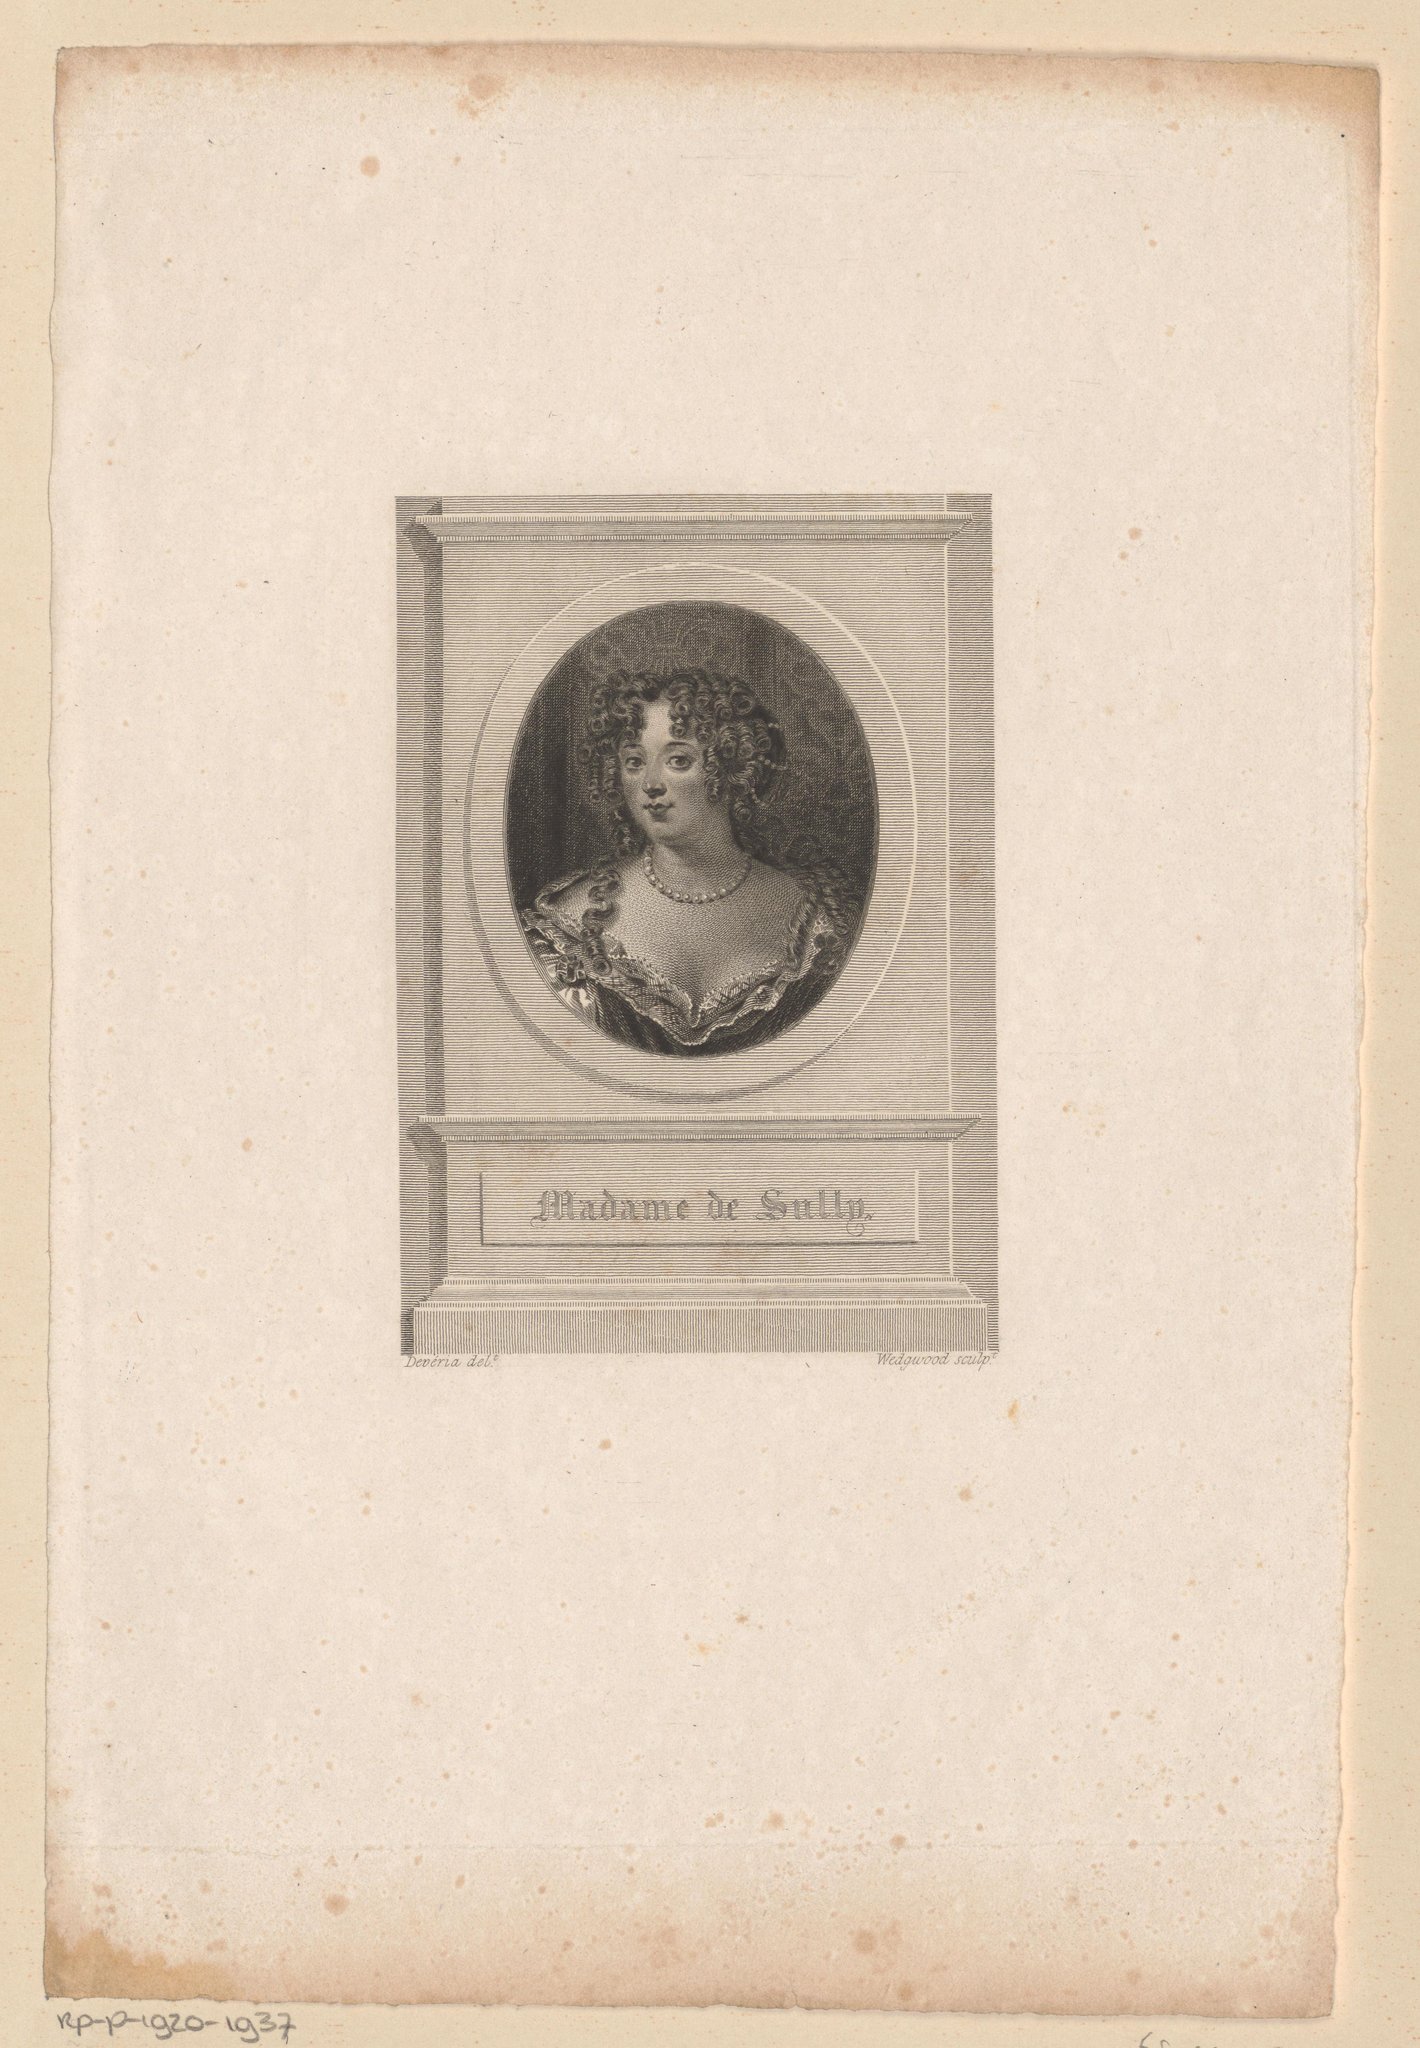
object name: print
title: Portret van Marie-Antoinette Servien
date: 1829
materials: paper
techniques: etching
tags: historical persons - bb - woman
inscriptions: collector's mark: Lugt 2228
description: Prent waarschijnlijk uit: Devéria, Dieu. Collection de 25 portraits des personnages les plus célèbres du Siècle de Louis XIV (...). Parijs: Lemarchand, 1829. p. 24.